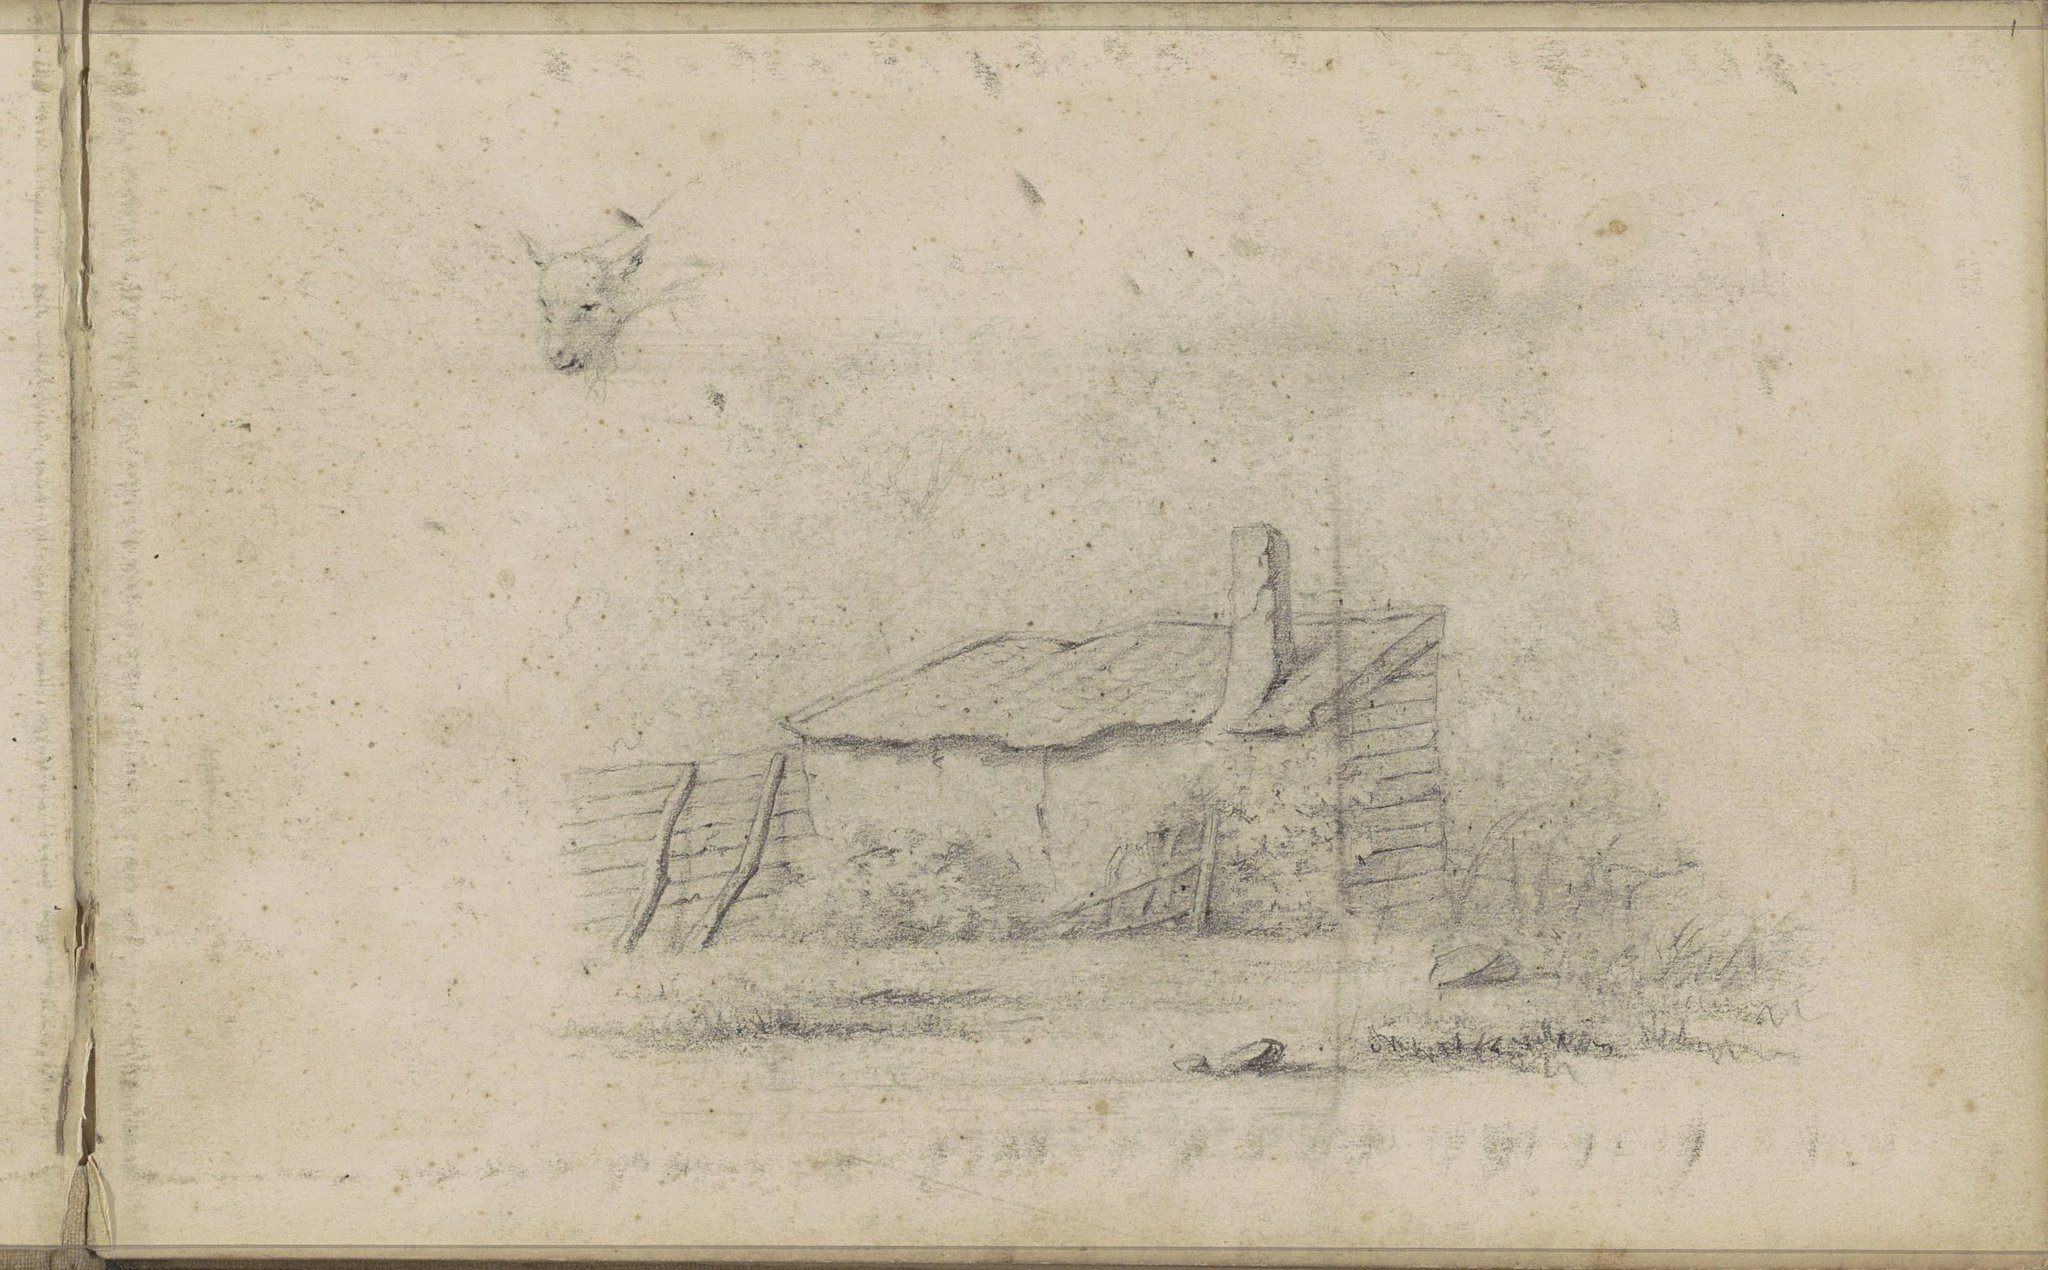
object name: sketchbook leaf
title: Schuur en een kop van een schaap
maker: willem cornelis rip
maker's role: draughtsman, painter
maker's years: 1856-1922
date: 1874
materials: paper, pencil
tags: barn, fence, wall, paling, sheep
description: Blad 1 recto uit een schetsboek met 47 bladen.